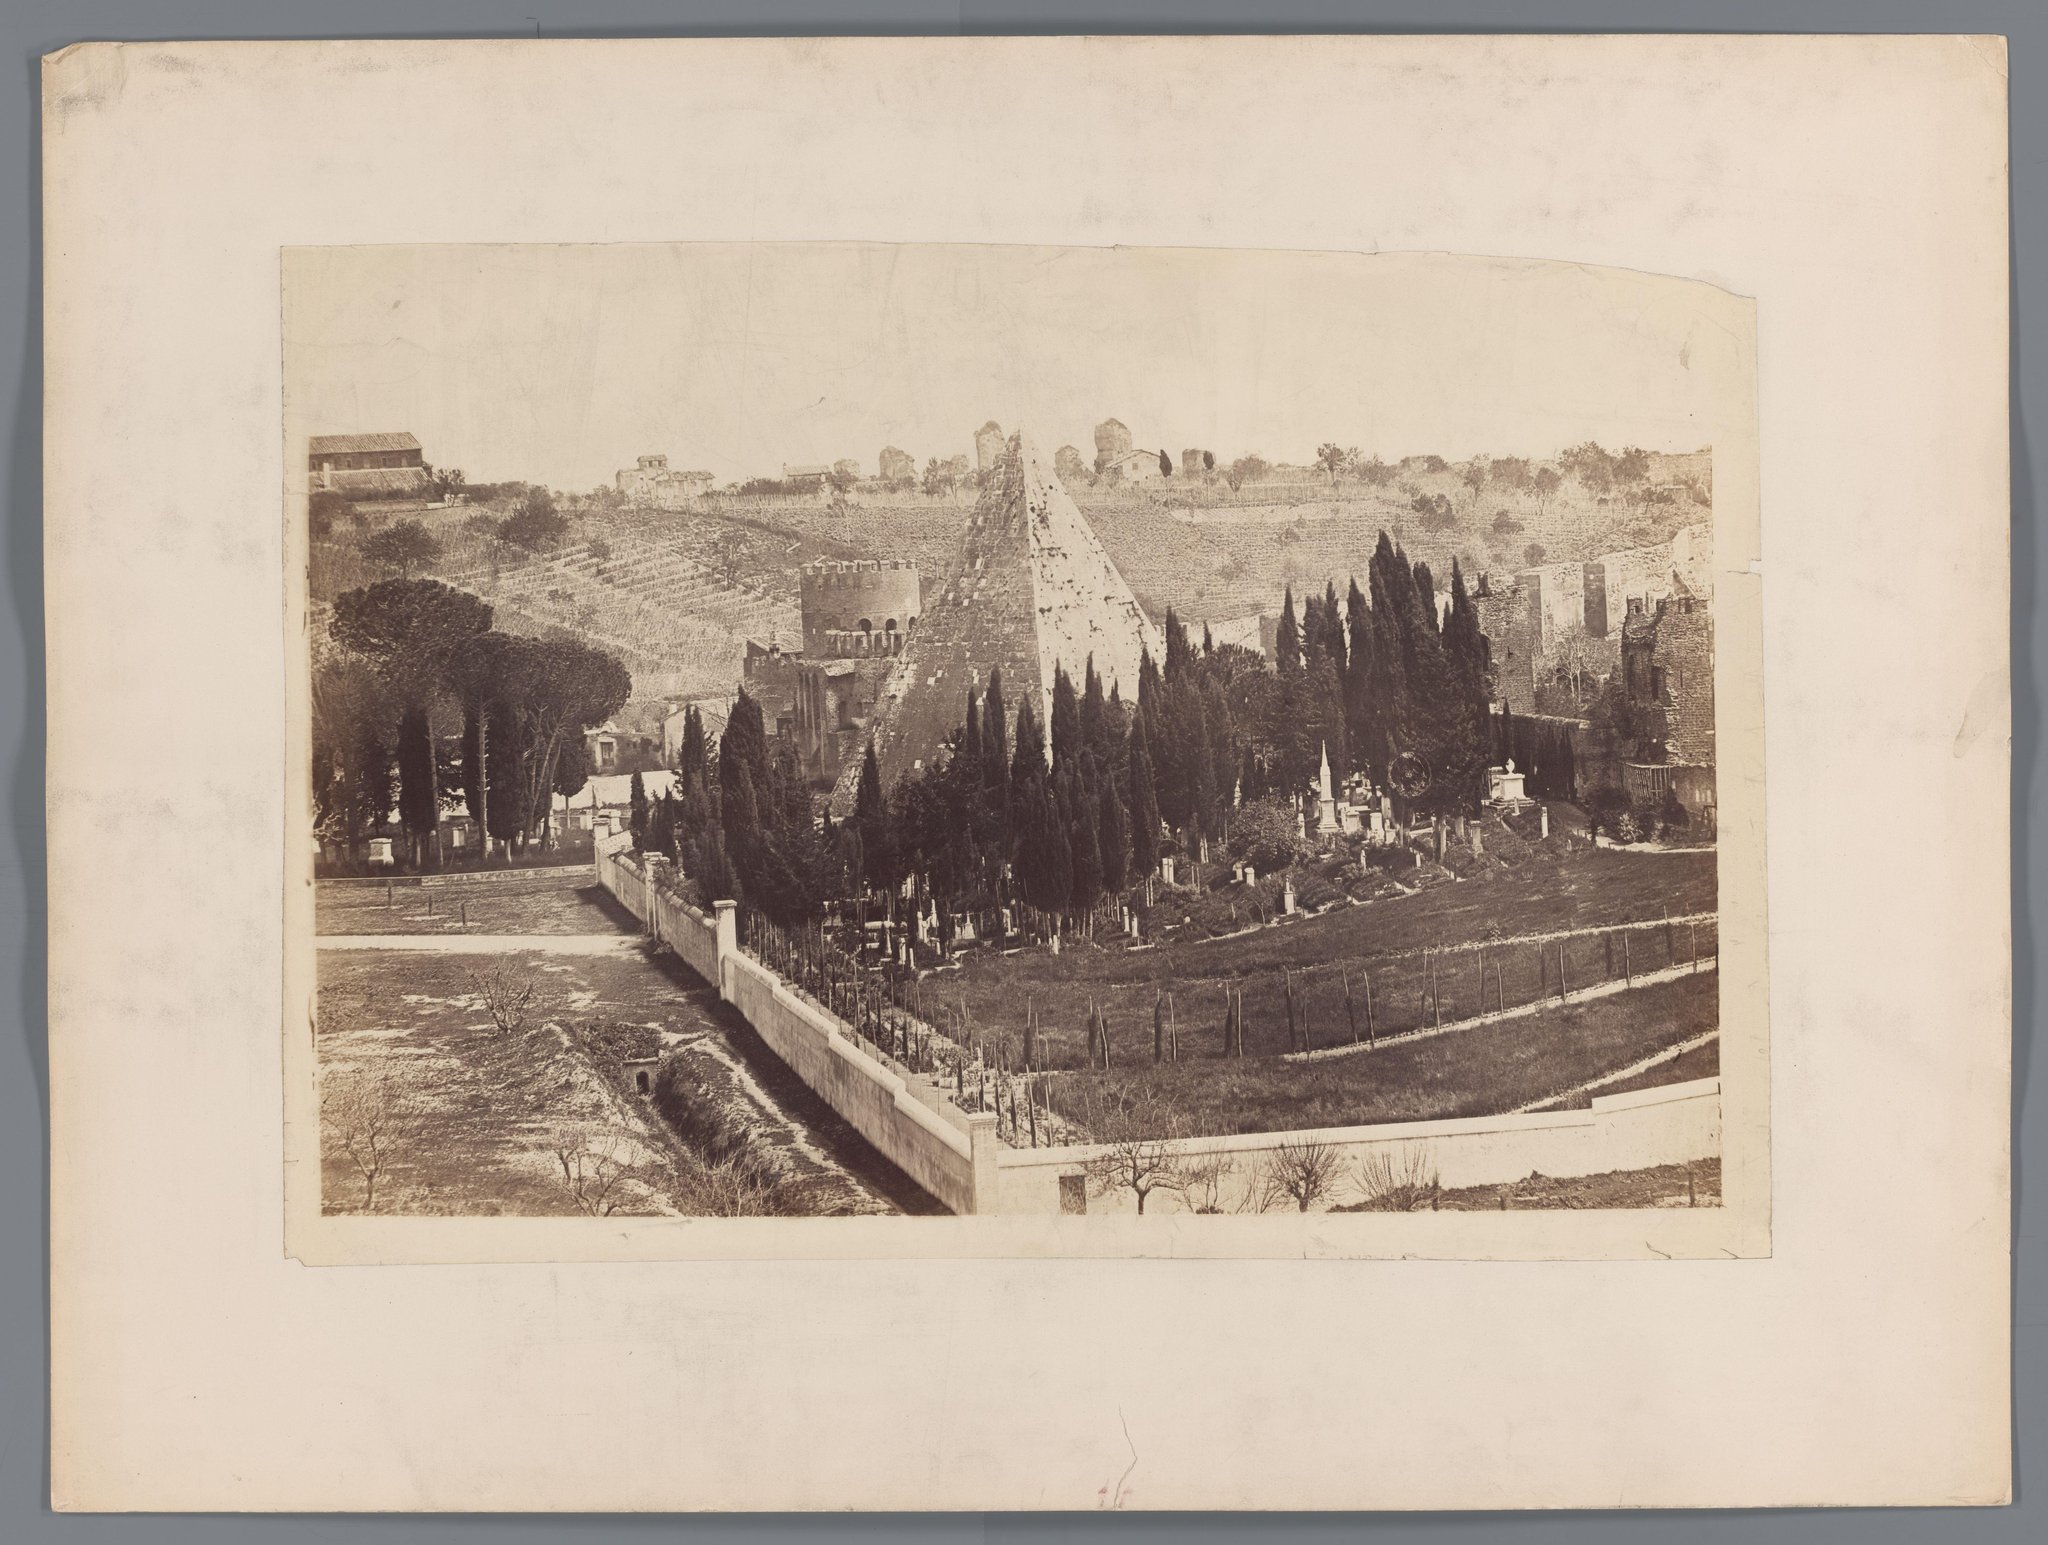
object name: photograph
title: Gezicht op de pyramide van Cestius te Rome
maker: gustave eugène chauffourier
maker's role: fotograaf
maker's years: 1845-1919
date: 1857-1875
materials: cardboard, paper, photographic support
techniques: albumen print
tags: piramide van cestius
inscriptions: stamp: ‘Rijksschool voor Kunstnijverheid’